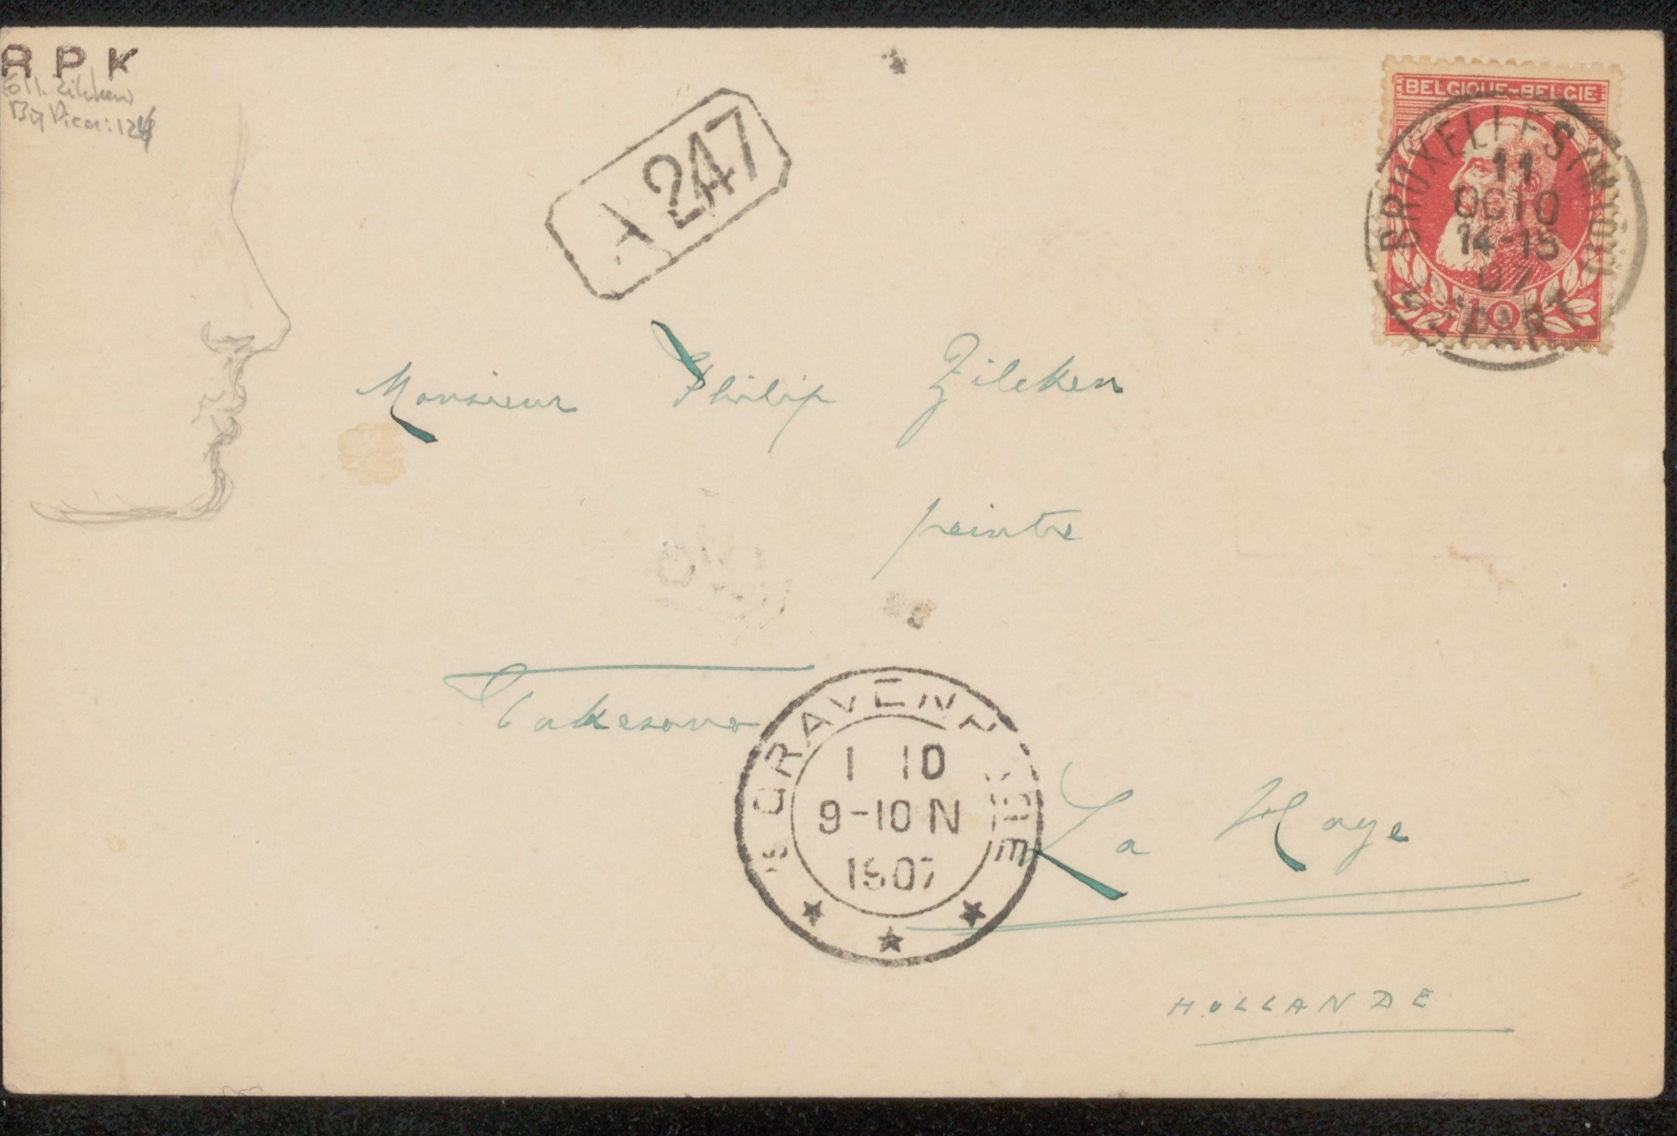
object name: letter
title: Brief aan Philip Zilcken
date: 1907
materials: cardboard, ink, pencil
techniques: pen, printing, writing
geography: brussels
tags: painter, draughtsman, philip zilcken, head (human) - aa - female human figure, the hague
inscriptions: collector's mark: ‘RPK’